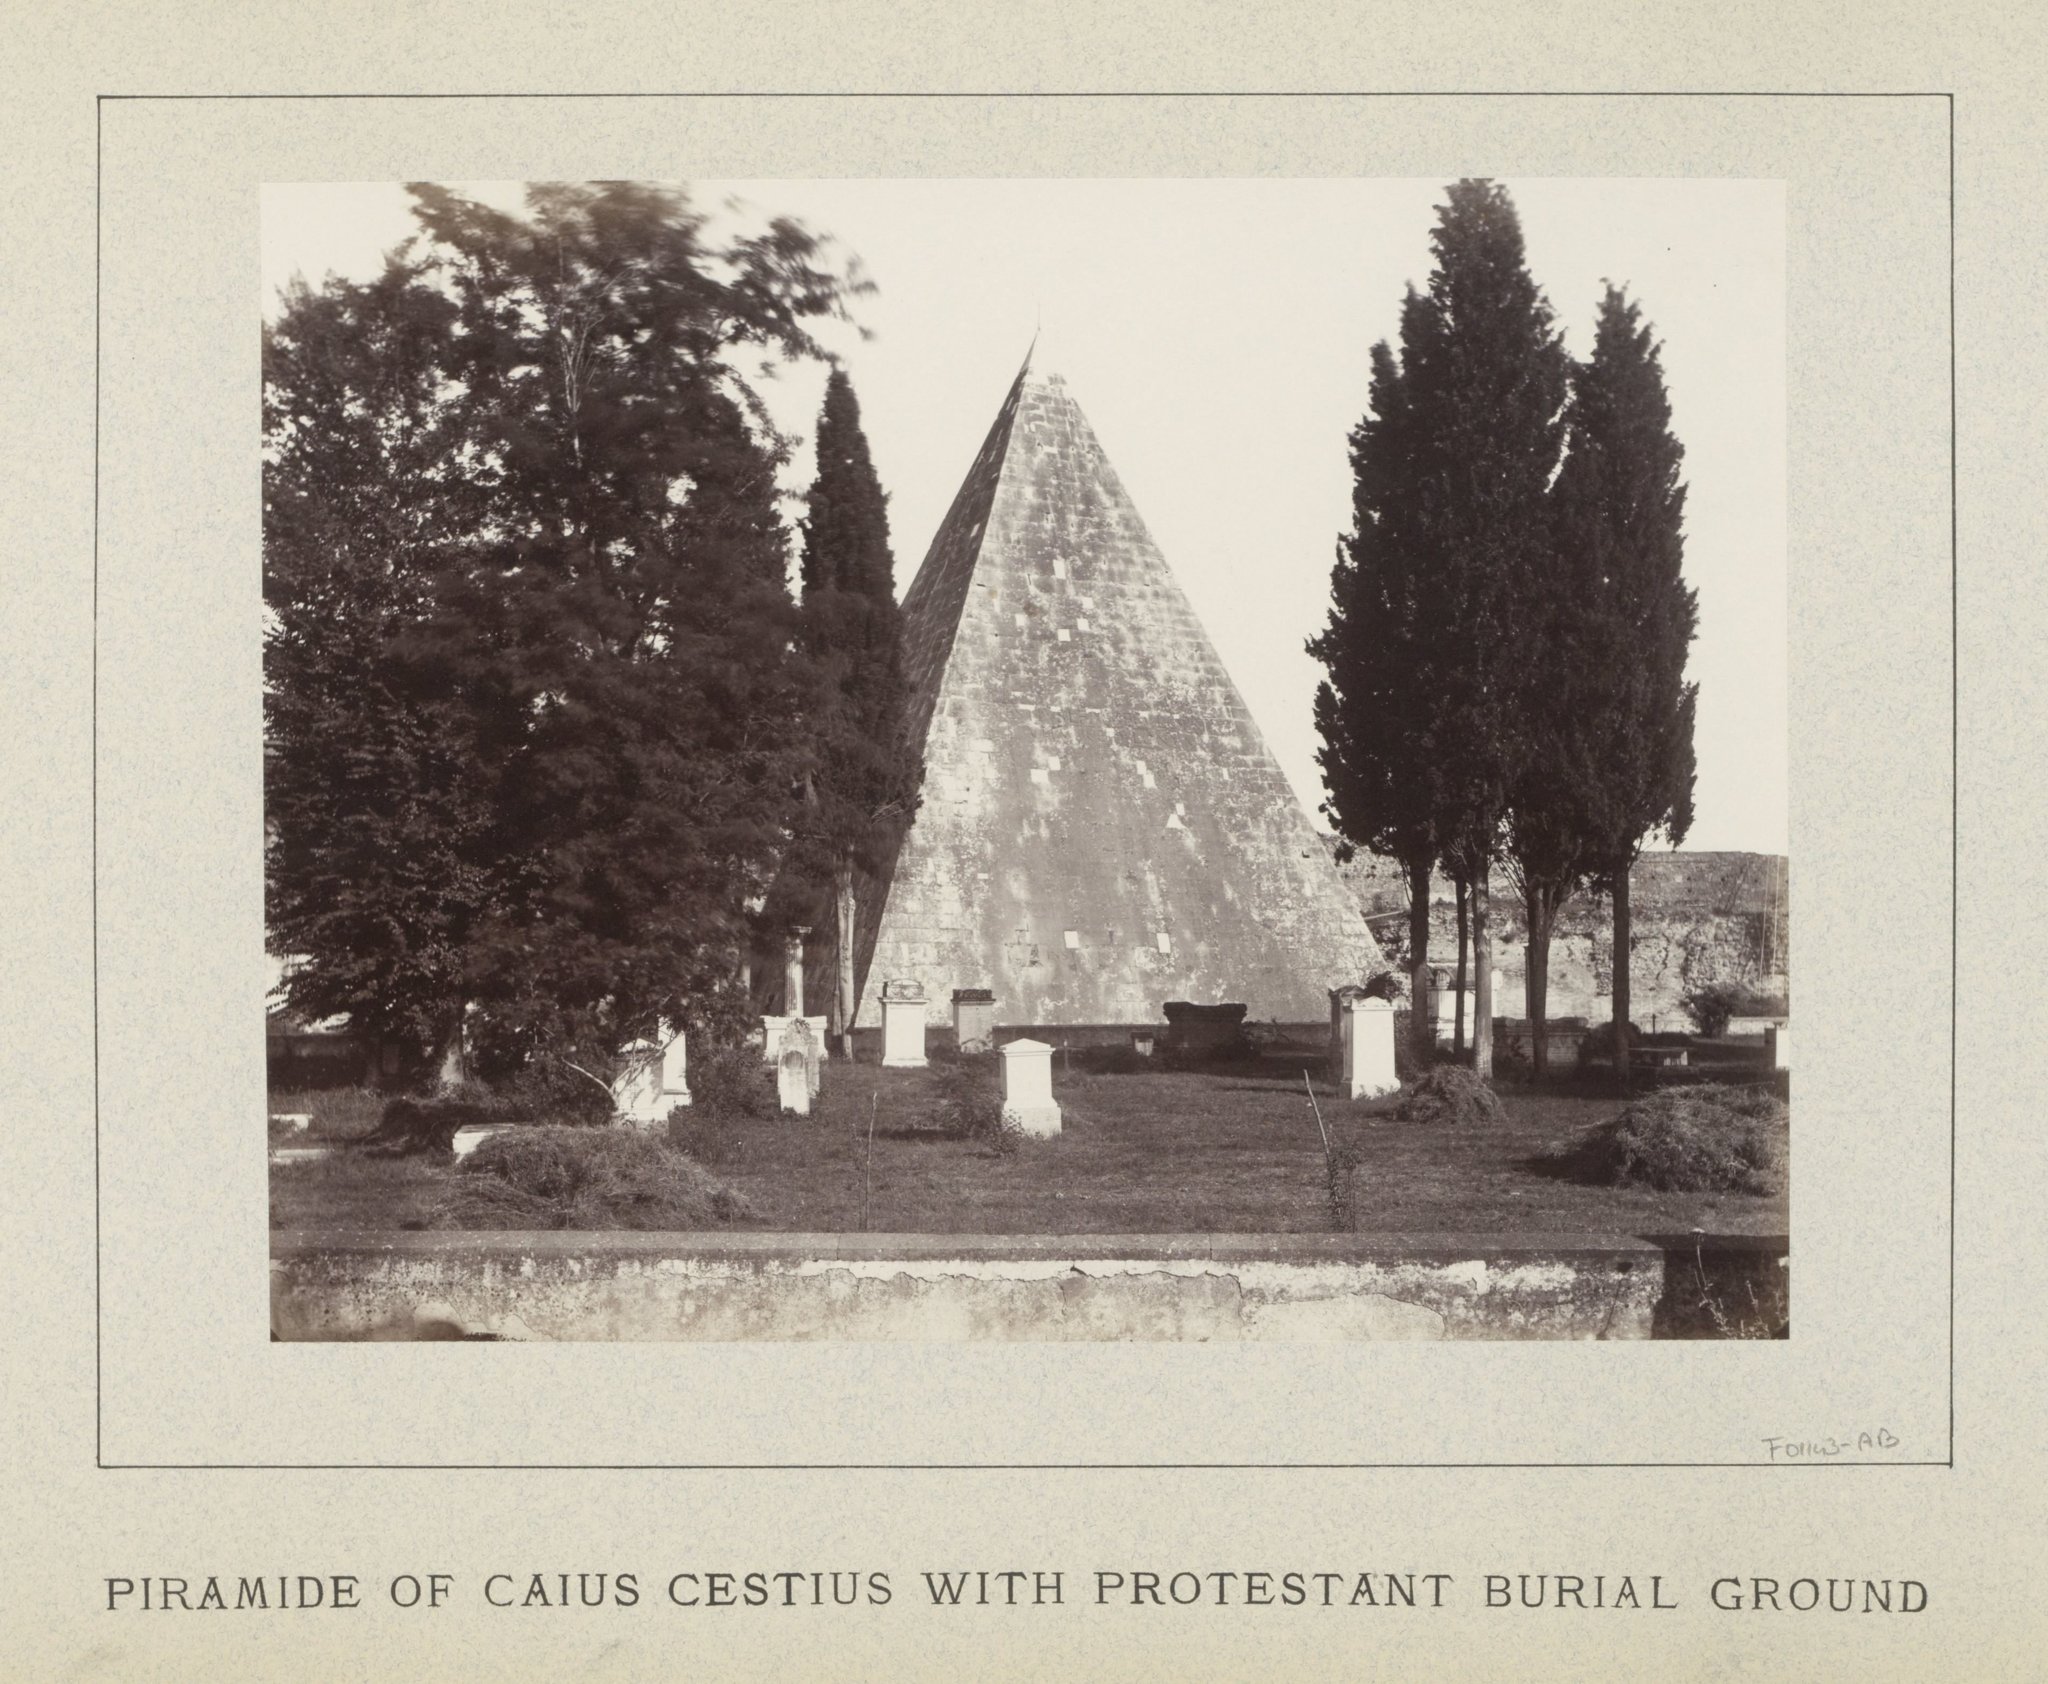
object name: photograph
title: Piramide of Caius Cestius with protestant burial ground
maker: Anonymous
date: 1860-1900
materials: photographic support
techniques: albumen print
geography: rome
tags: pyramid (historical grave form), gravestone, tombstone, cemetery, park-like burying ground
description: Onderdeel van Fotoalbum met opnames van bezienswaardigheden en kunstwerken in Rome.